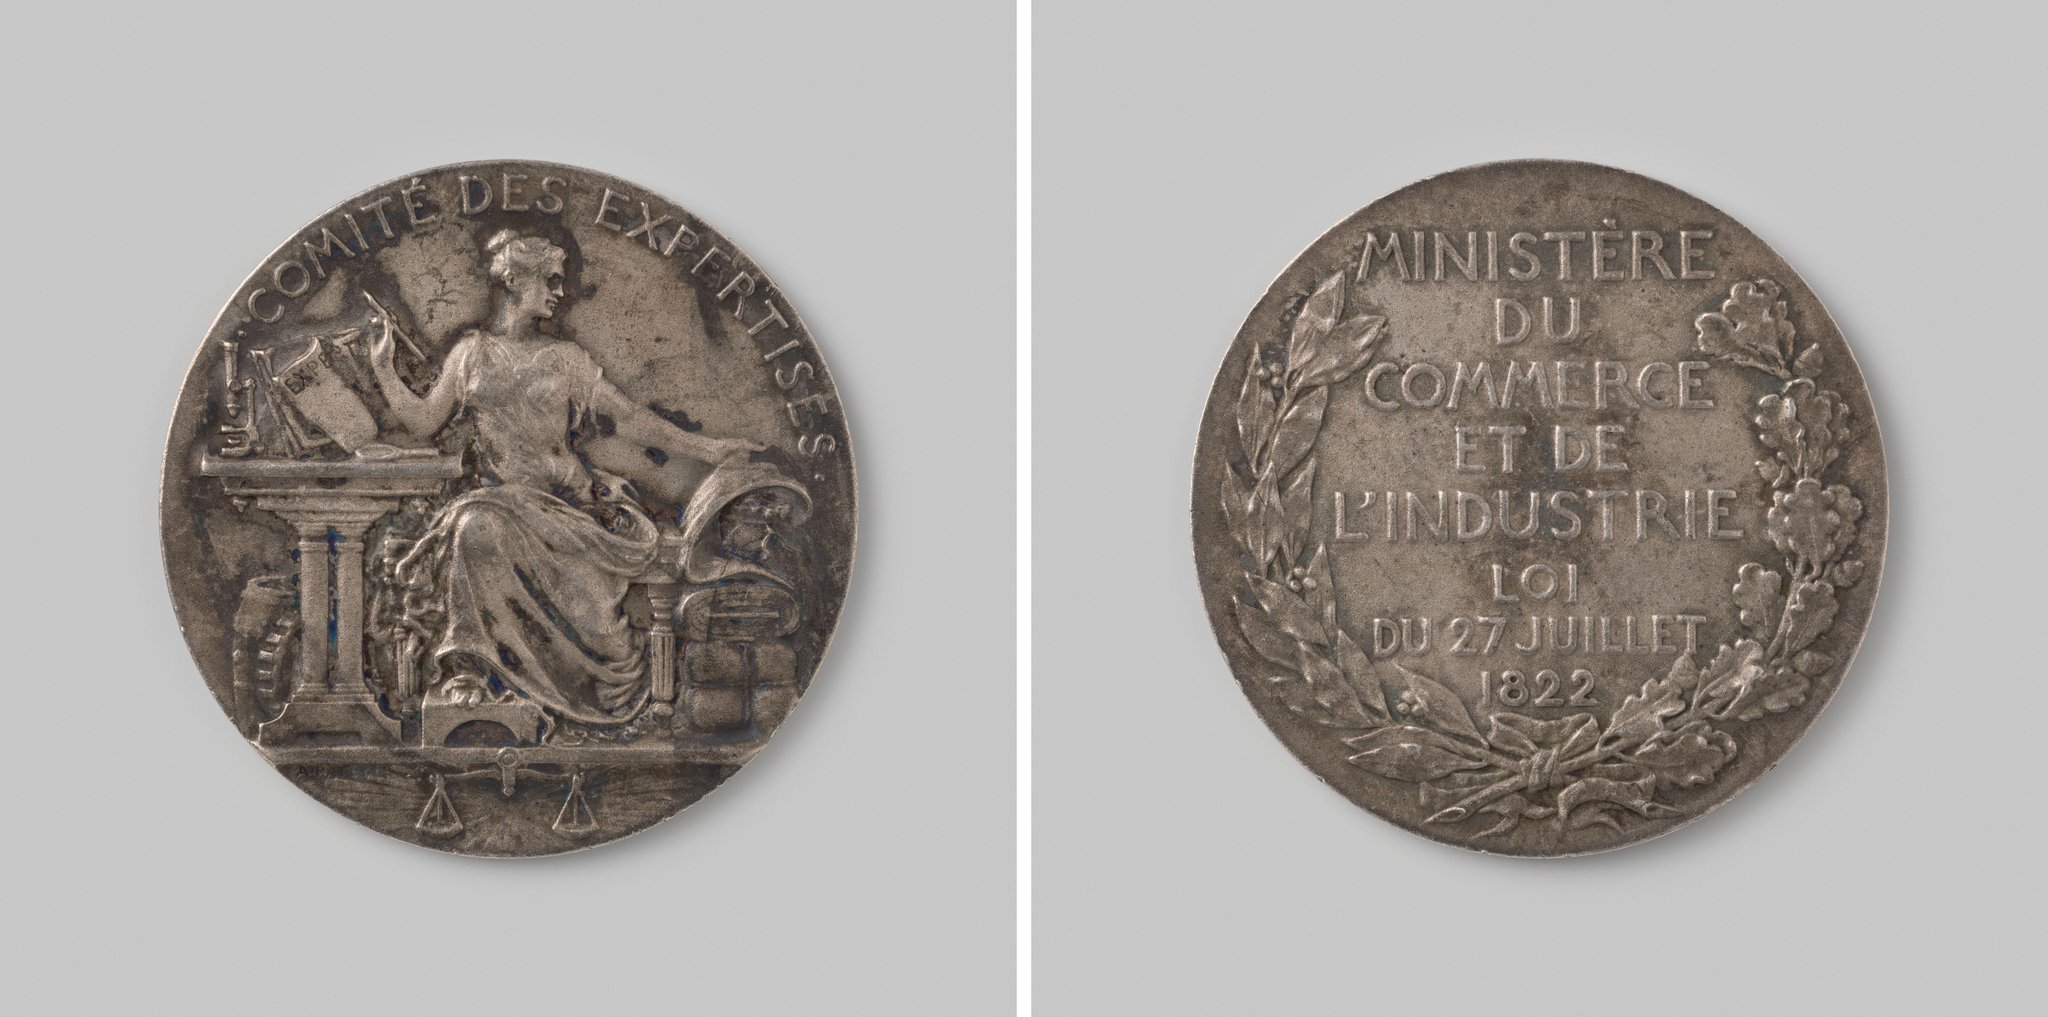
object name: history medal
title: Honderdjarig bestaan (?) van het Comité des Expertises in Frankrijk 1922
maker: auguste paty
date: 1922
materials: silver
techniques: striking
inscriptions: hallmark: ‘(hoorn des overvloeds) ARGENT’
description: Zilveren penning, op de voorzijde een vrouw, schrijvend aan een kolomtafel waarop een microscoop, de kwaliteit van een rol taxtiel keurend, met bovenaan omschrift, op de keerzijde acht regels tekst tussen samengestrikte lauwer- en eikentakken.